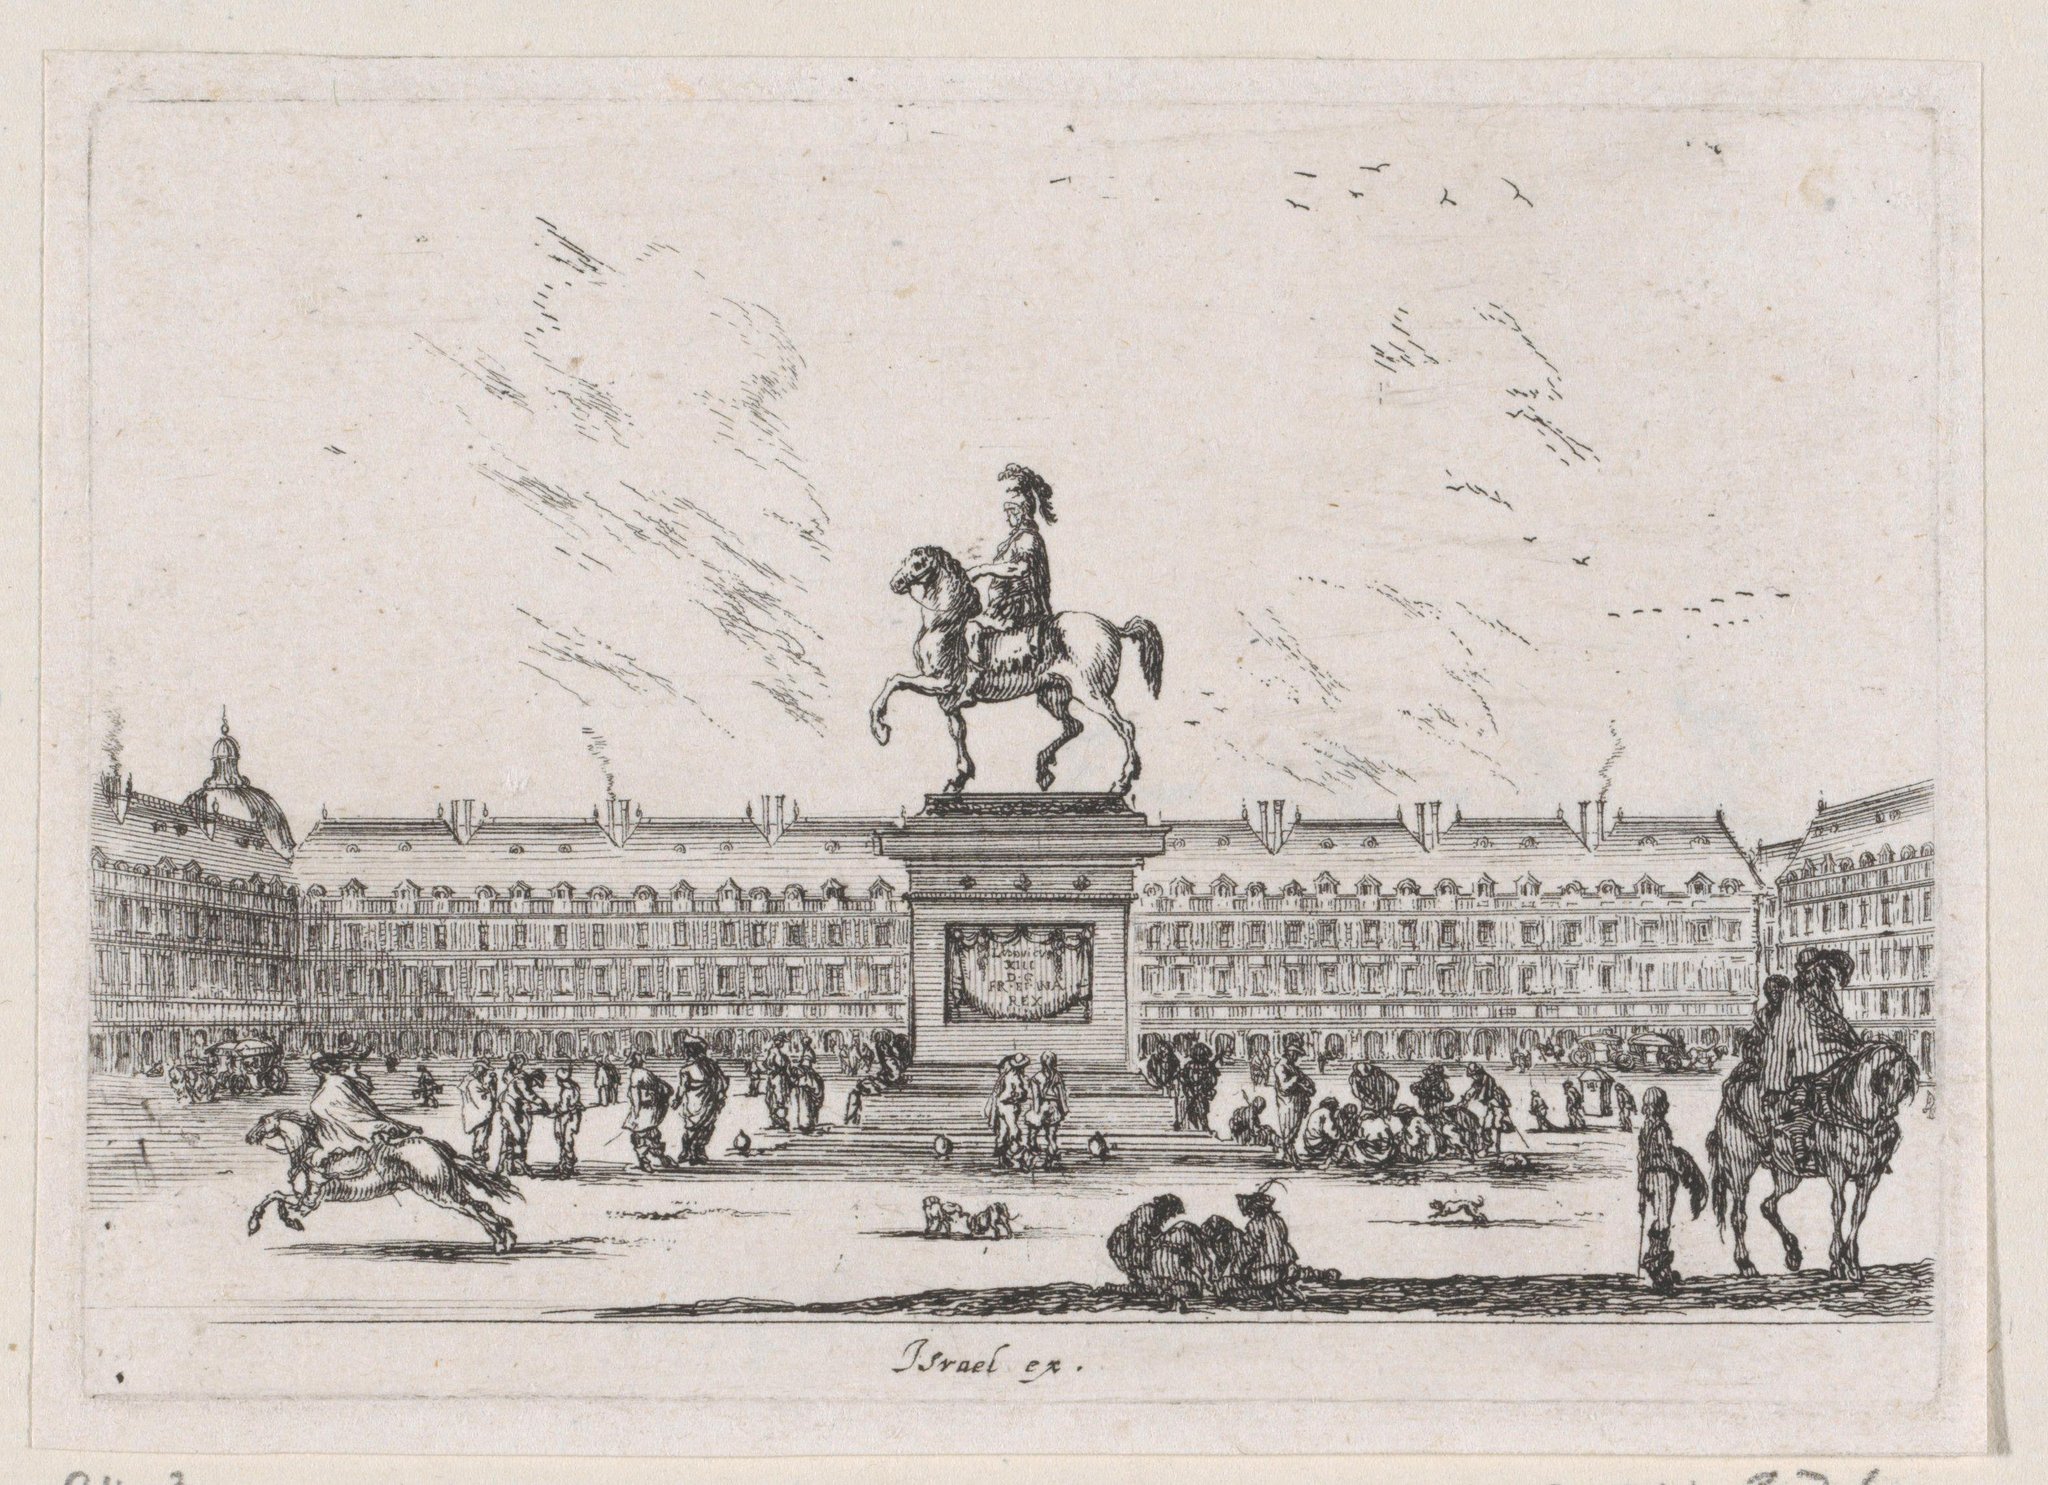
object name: print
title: Place des Vosges in Parijs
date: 1642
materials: paper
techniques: etching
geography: france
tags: square, place, circus, etc.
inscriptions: collector's mark: Lugt 240